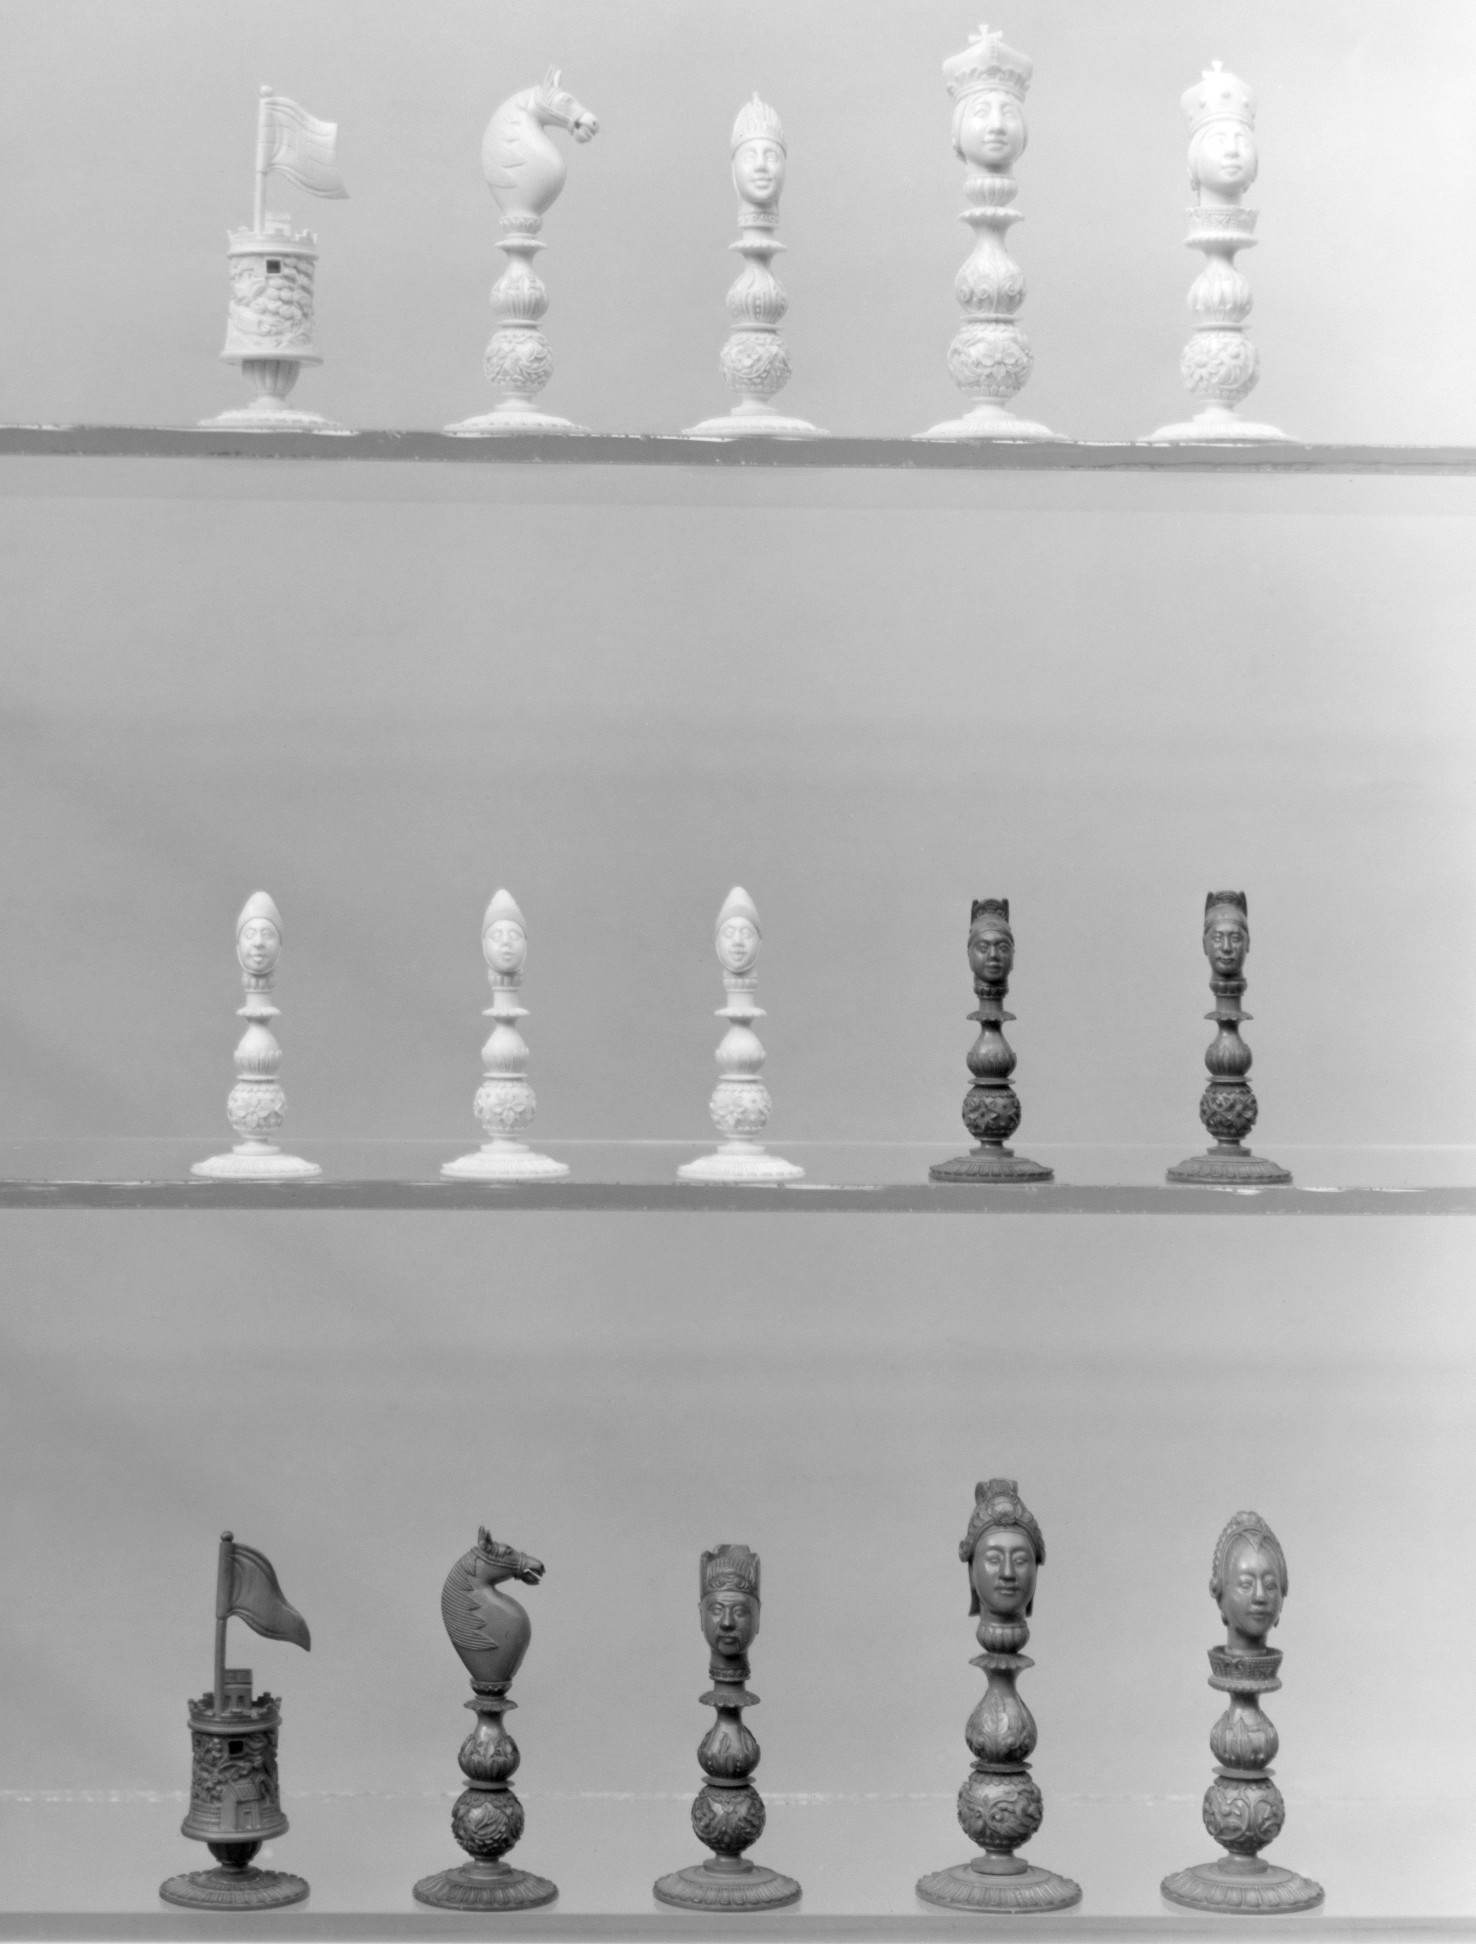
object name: chessman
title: Chessmen (32)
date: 1867-1900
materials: ivory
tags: chess,games